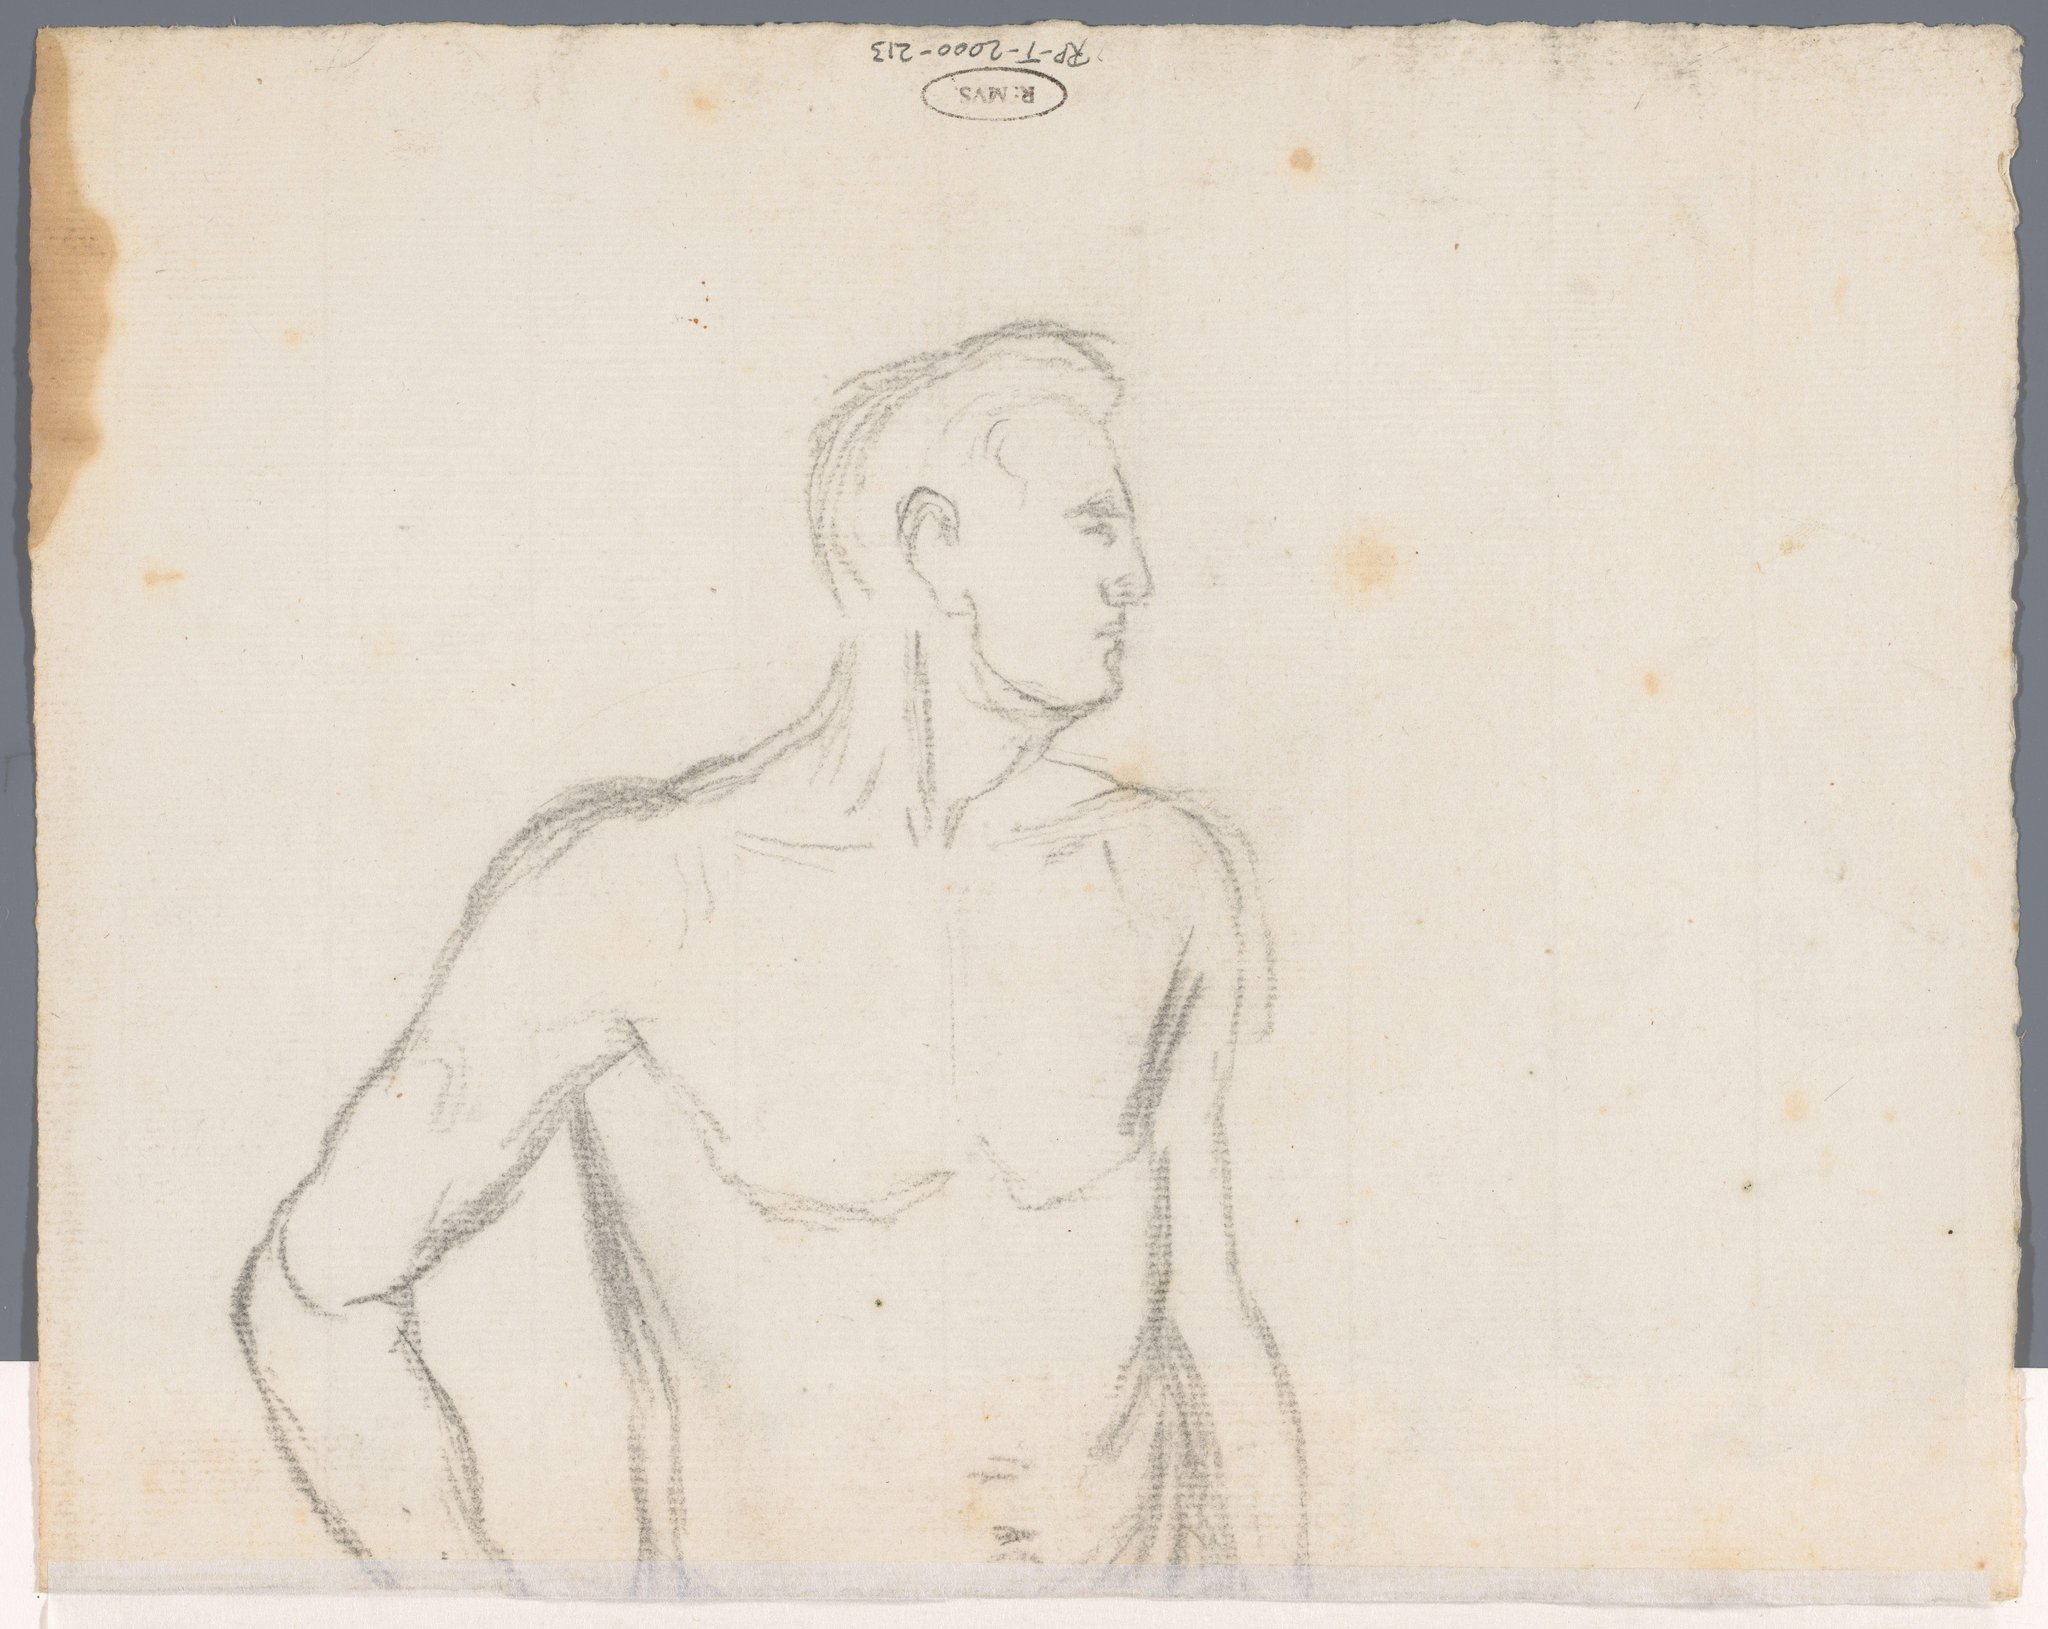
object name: drawing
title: Mannelijk naakt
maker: johannes tavenraat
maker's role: draughtsman, painter, print maker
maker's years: 1809-1881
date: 1853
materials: paper, pencil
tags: standing figure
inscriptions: collector's mark: Lugt 2228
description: Academische studie van mannelijk naakt (fragment).